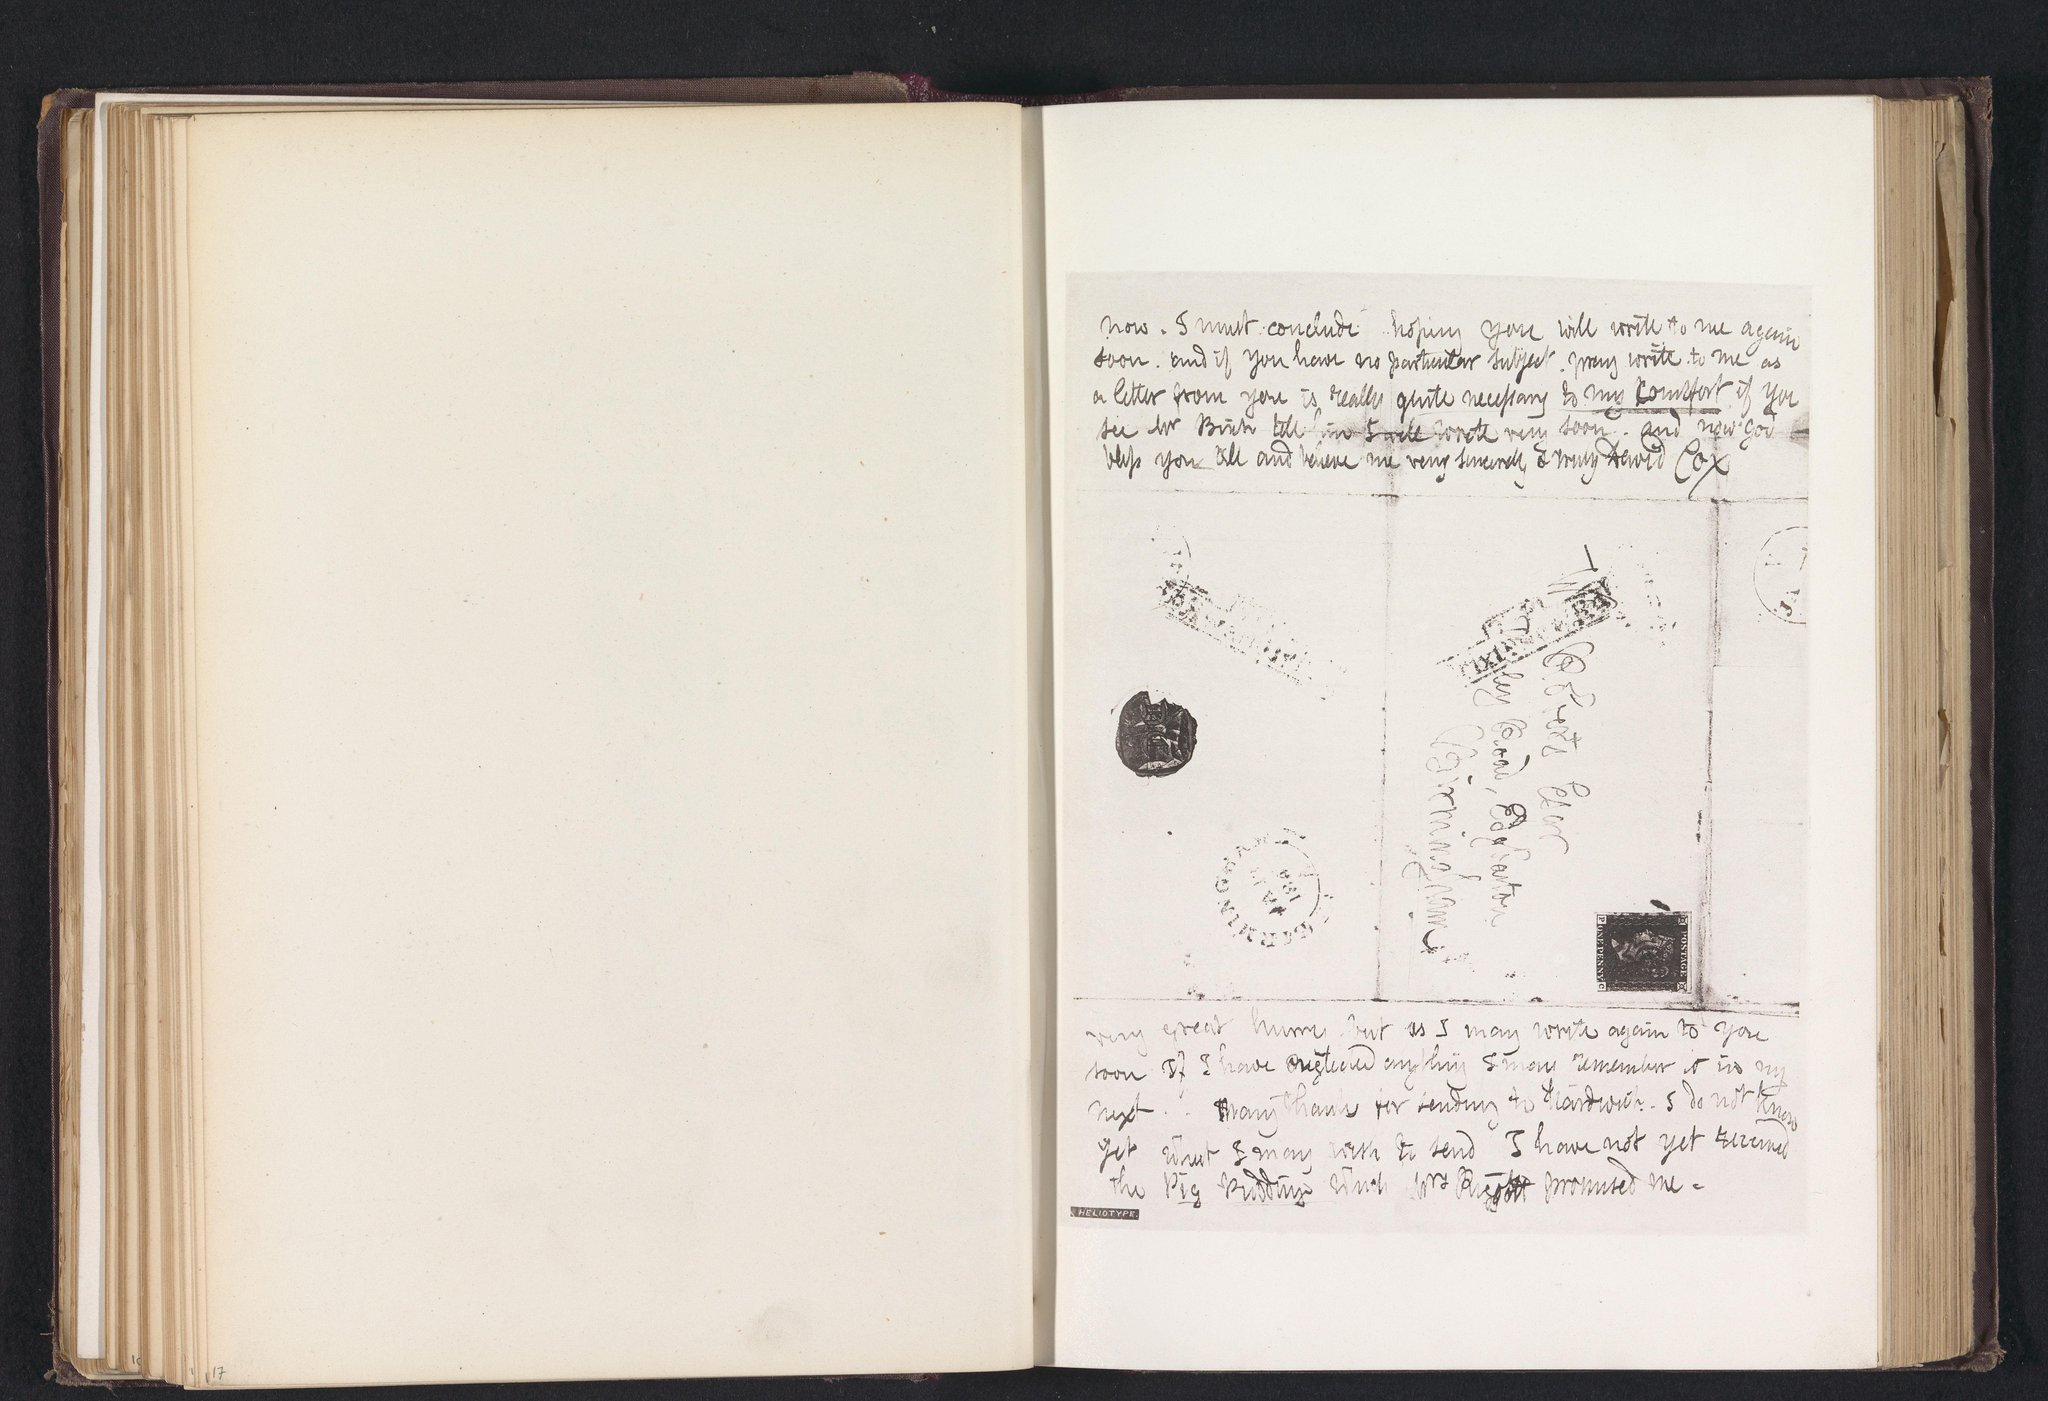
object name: photomechanical print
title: Fotoreproductie van een brief met een envelop van David Cox aan William Roberts op 12 januari van 1841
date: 1863-1873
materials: paper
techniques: photoaquatint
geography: london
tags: letter, envelope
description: RP-F-2001-7-66-15 tot en met RP-F-2001-7-66-18 vormen vermoedelijk samen een brief.